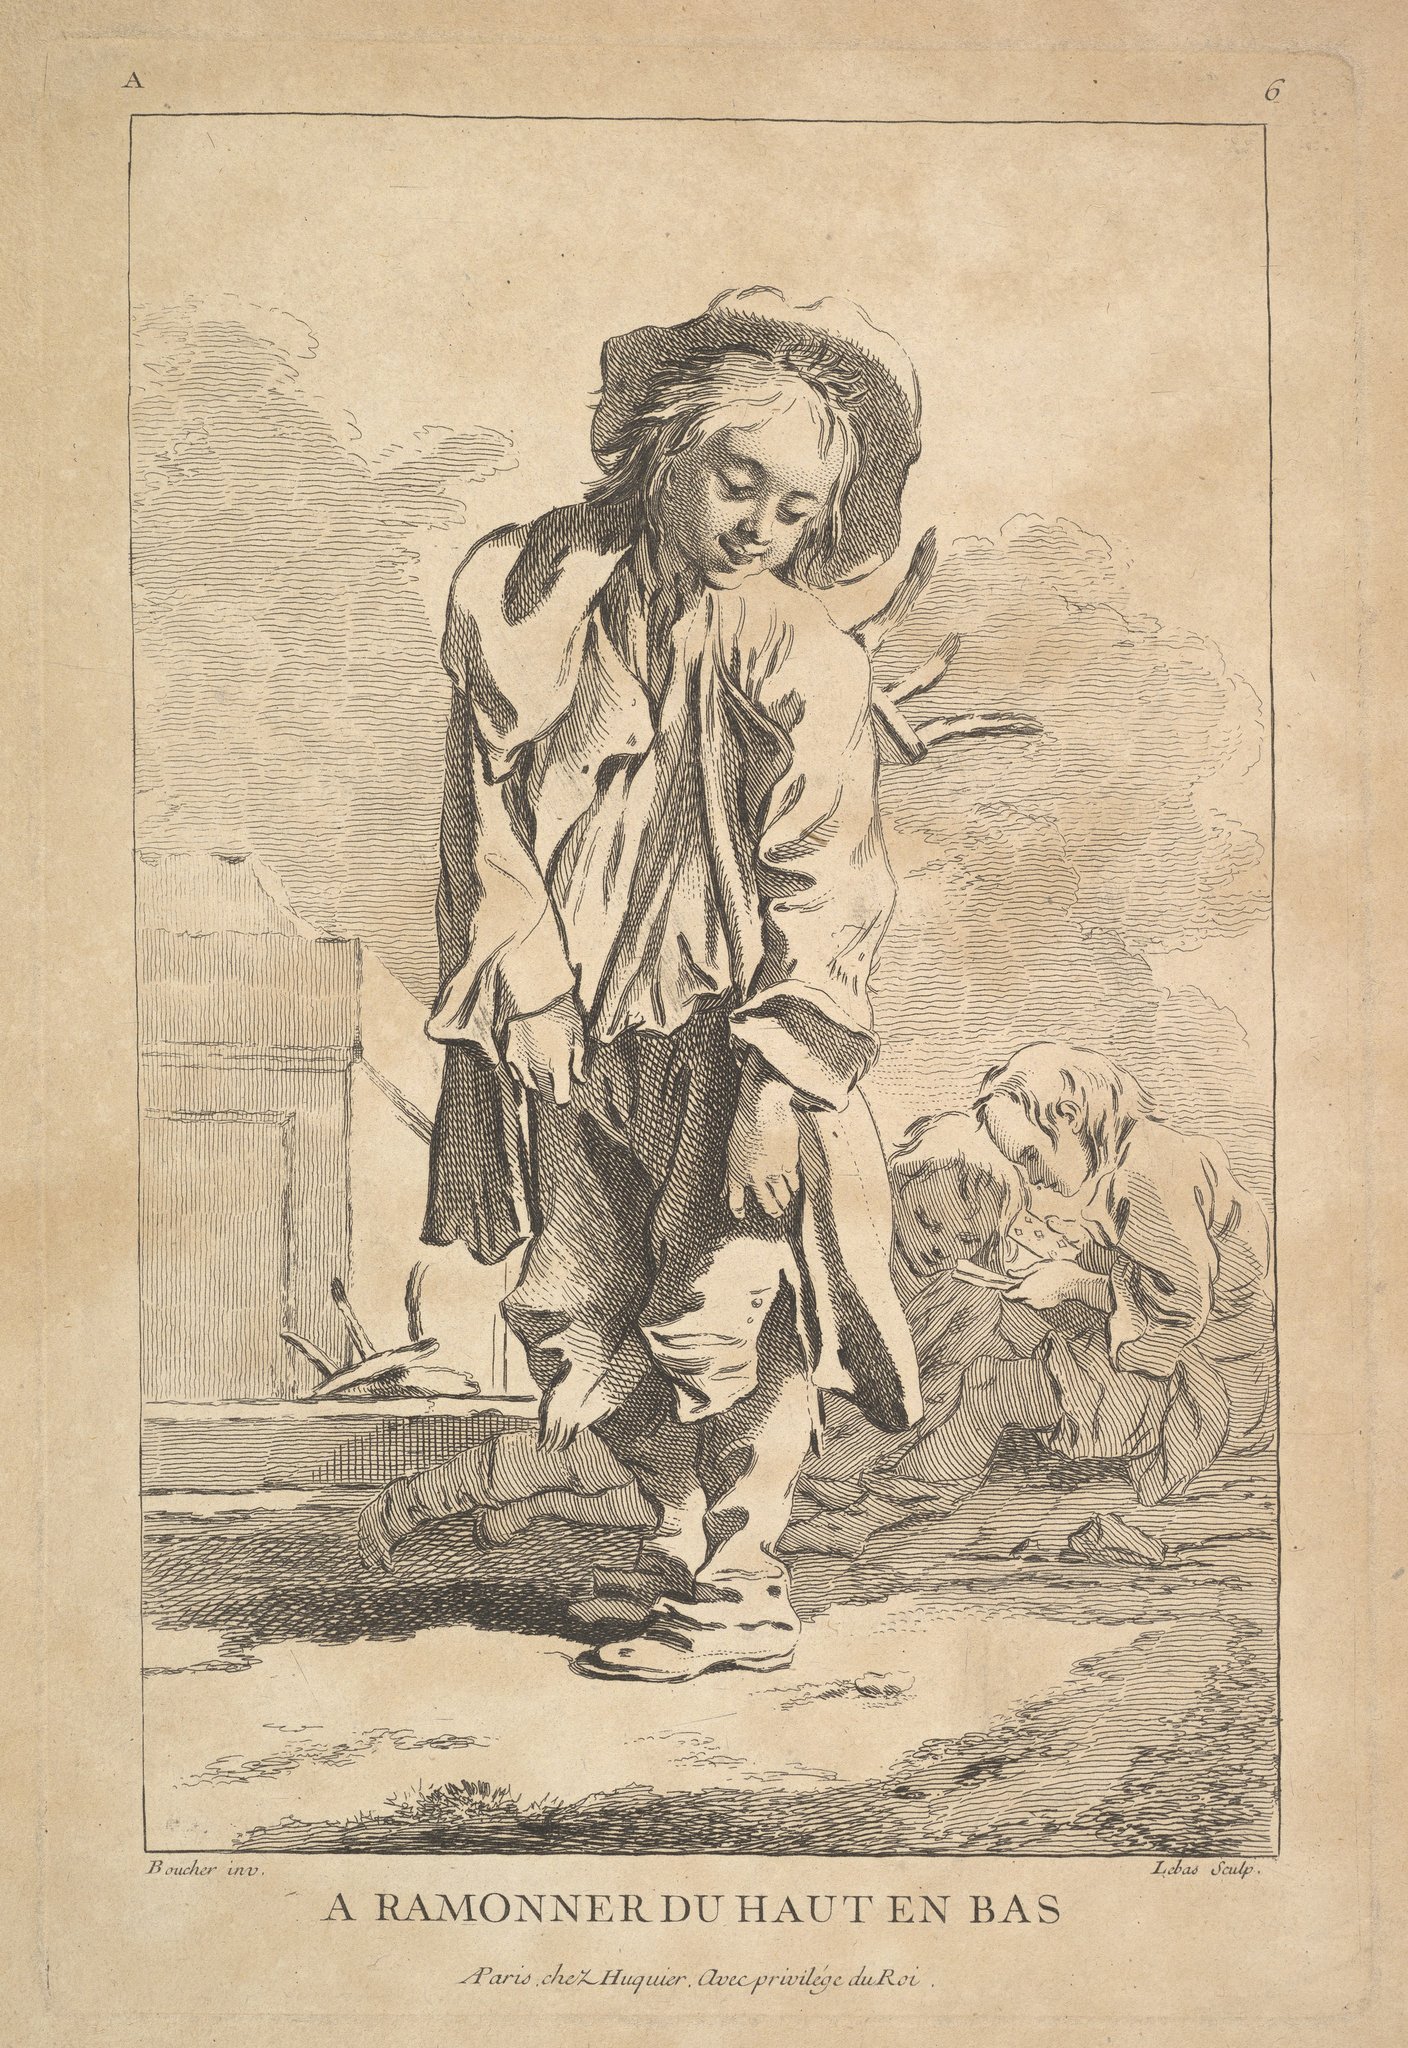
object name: print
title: Sweeping from Top to Bottom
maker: jacques philippe le bas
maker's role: artist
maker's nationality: french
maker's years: 1707-1783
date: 1707-1783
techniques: engraving, etching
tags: men